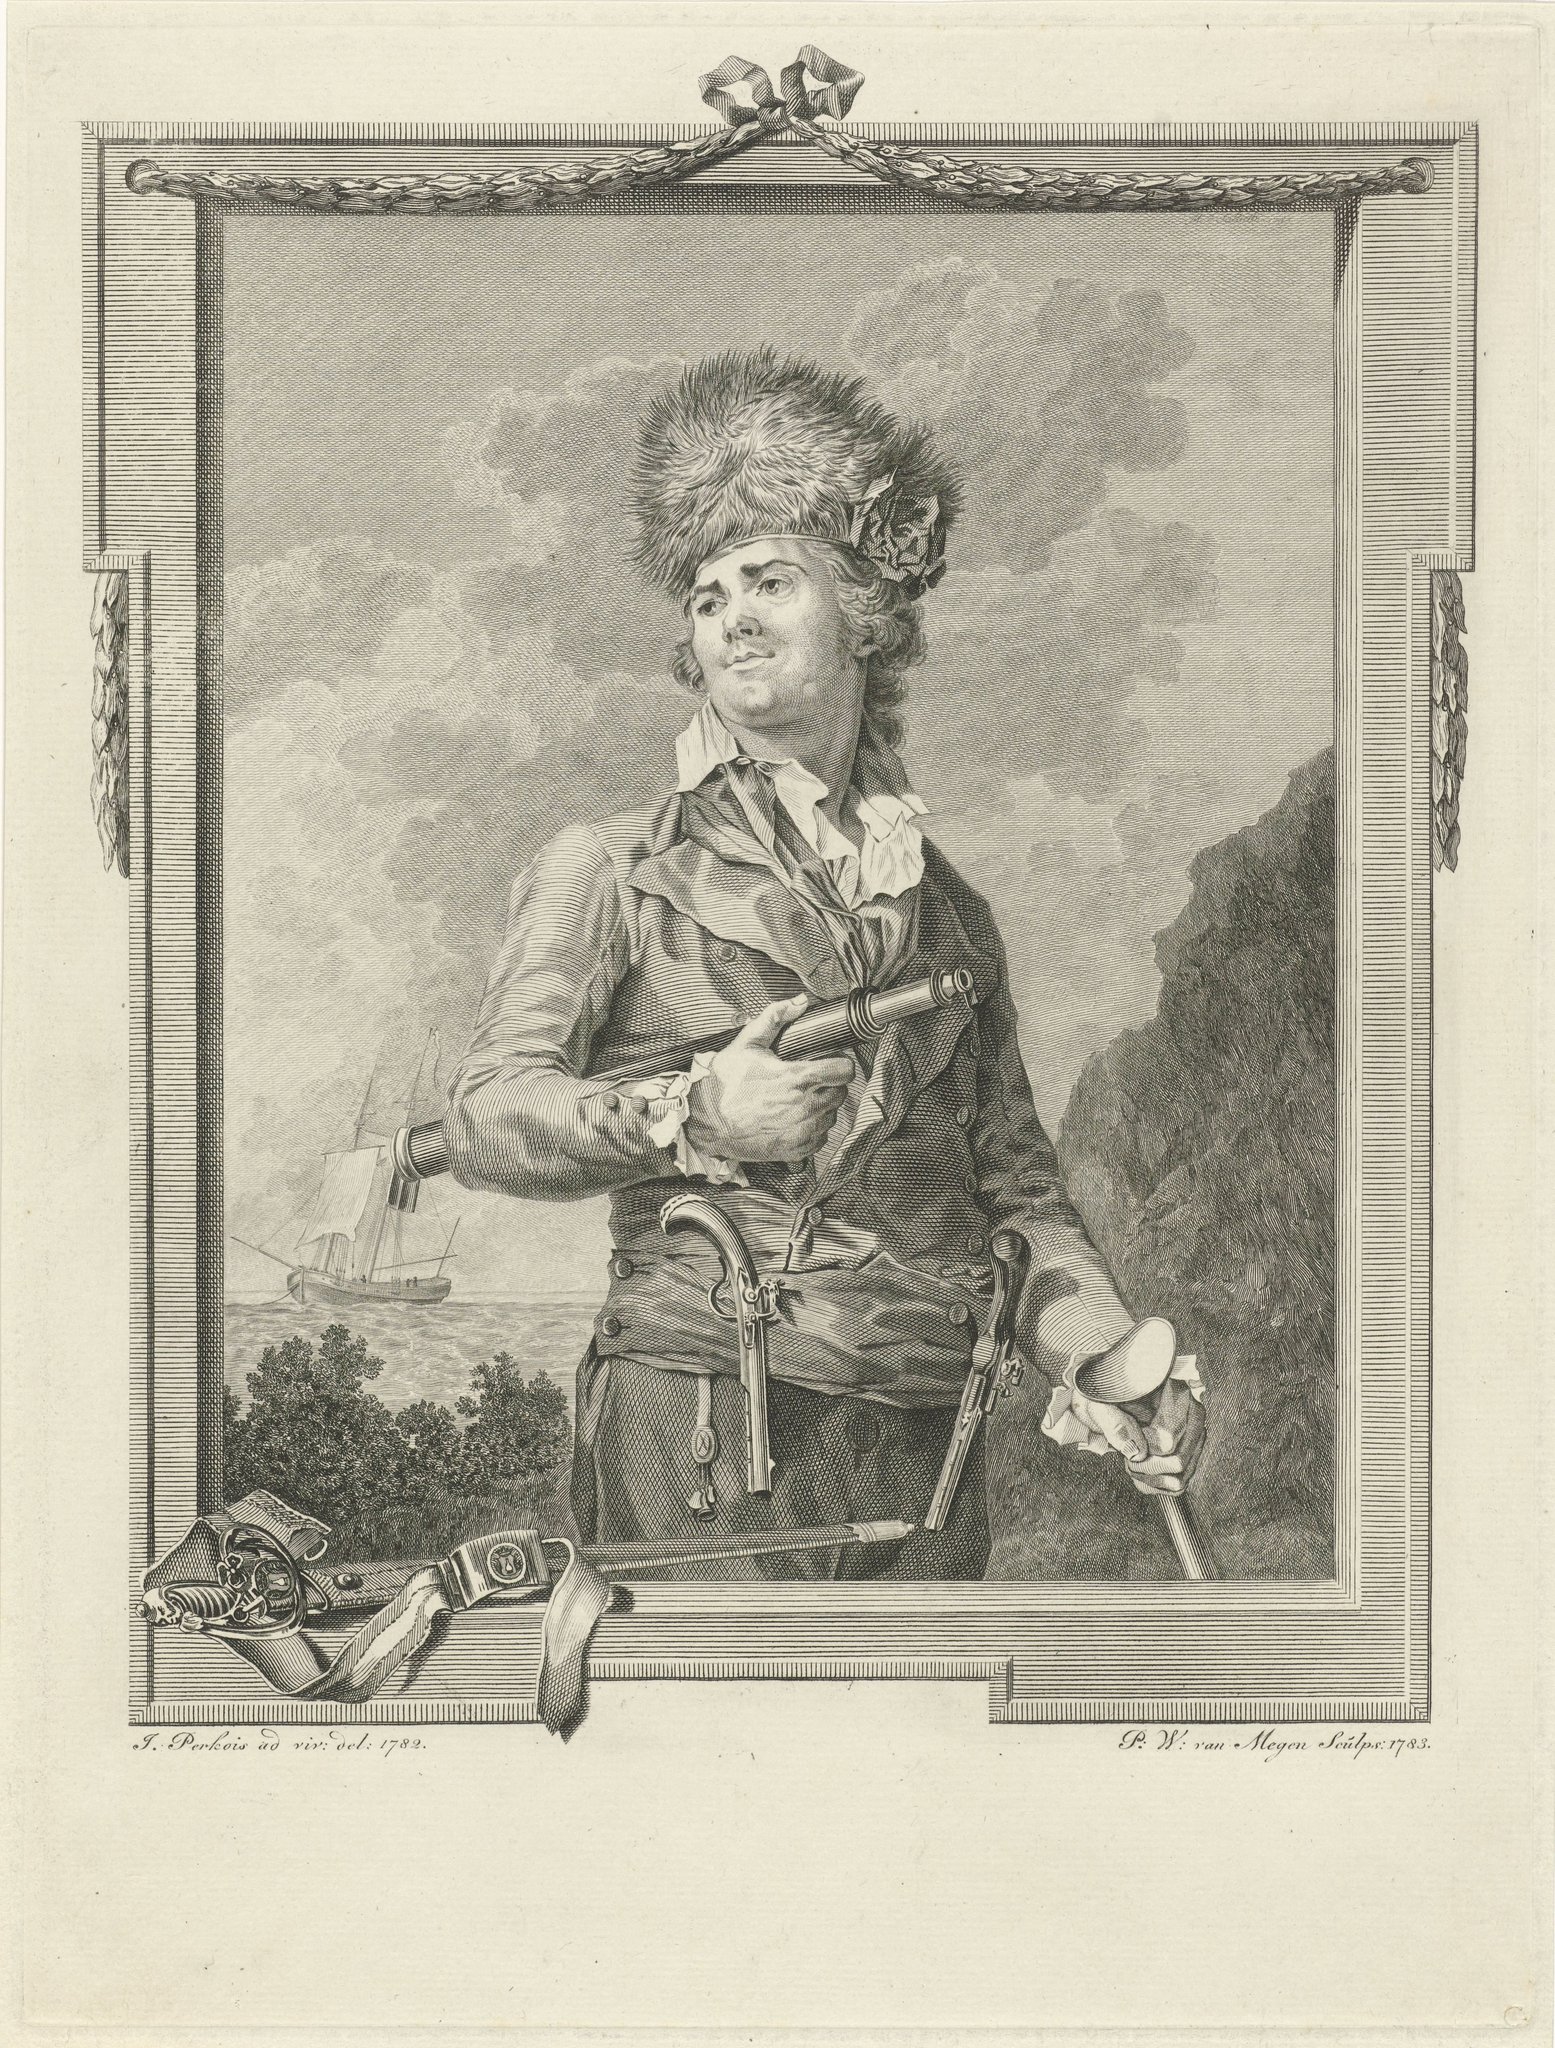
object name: print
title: Portret van Pierre le Turcq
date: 1783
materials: paper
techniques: engraving, etching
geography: the hague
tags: capuche, pirate, corsair, buccaneer, ship's portrait, hacking and thrusting weapons: sword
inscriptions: collector's mark: Lugt 2228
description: Portret van kaper en kapitein Pierre le Turcq met een verrekijker onder zijn arm en pistolen aan zijn jas. Op de achtergrond zijn schip 'De Zeeuw'. Onder op de lijst ligt een sabel.